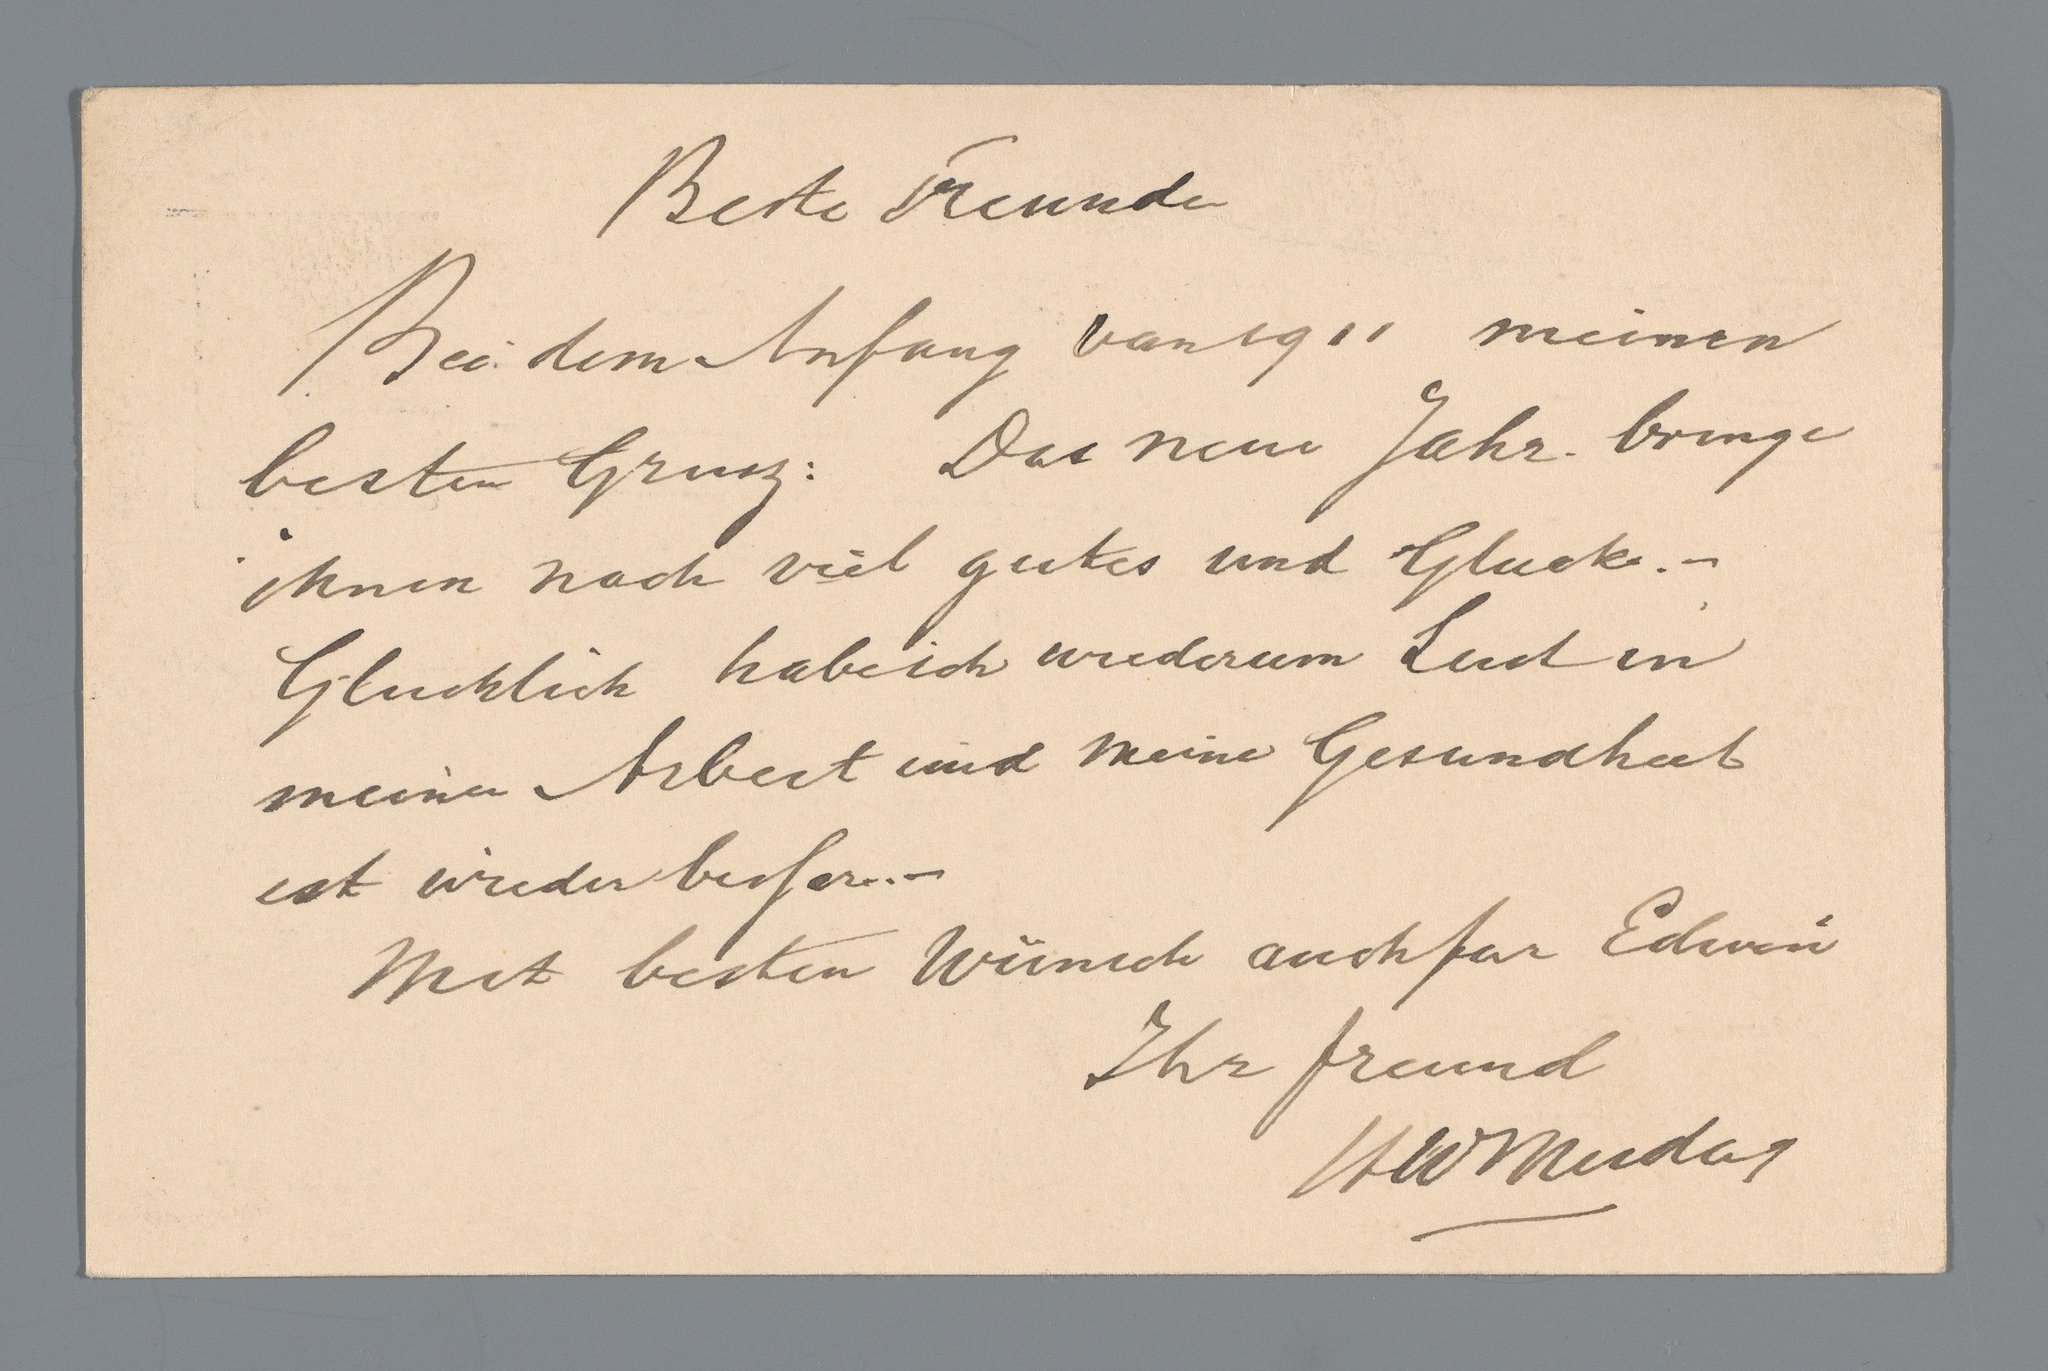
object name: postcard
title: Briefkaart aan Johanna Behrend-Croiset van der Kop in Mainz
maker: hendrik willem mesdag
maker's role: draughtsman, painter, print maker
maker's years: 1831-1915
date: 1910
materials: cardboard, ink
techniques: writing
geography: netherlands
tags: utrecht, painter, draughtsman, johanna behrend-croiset van der kop